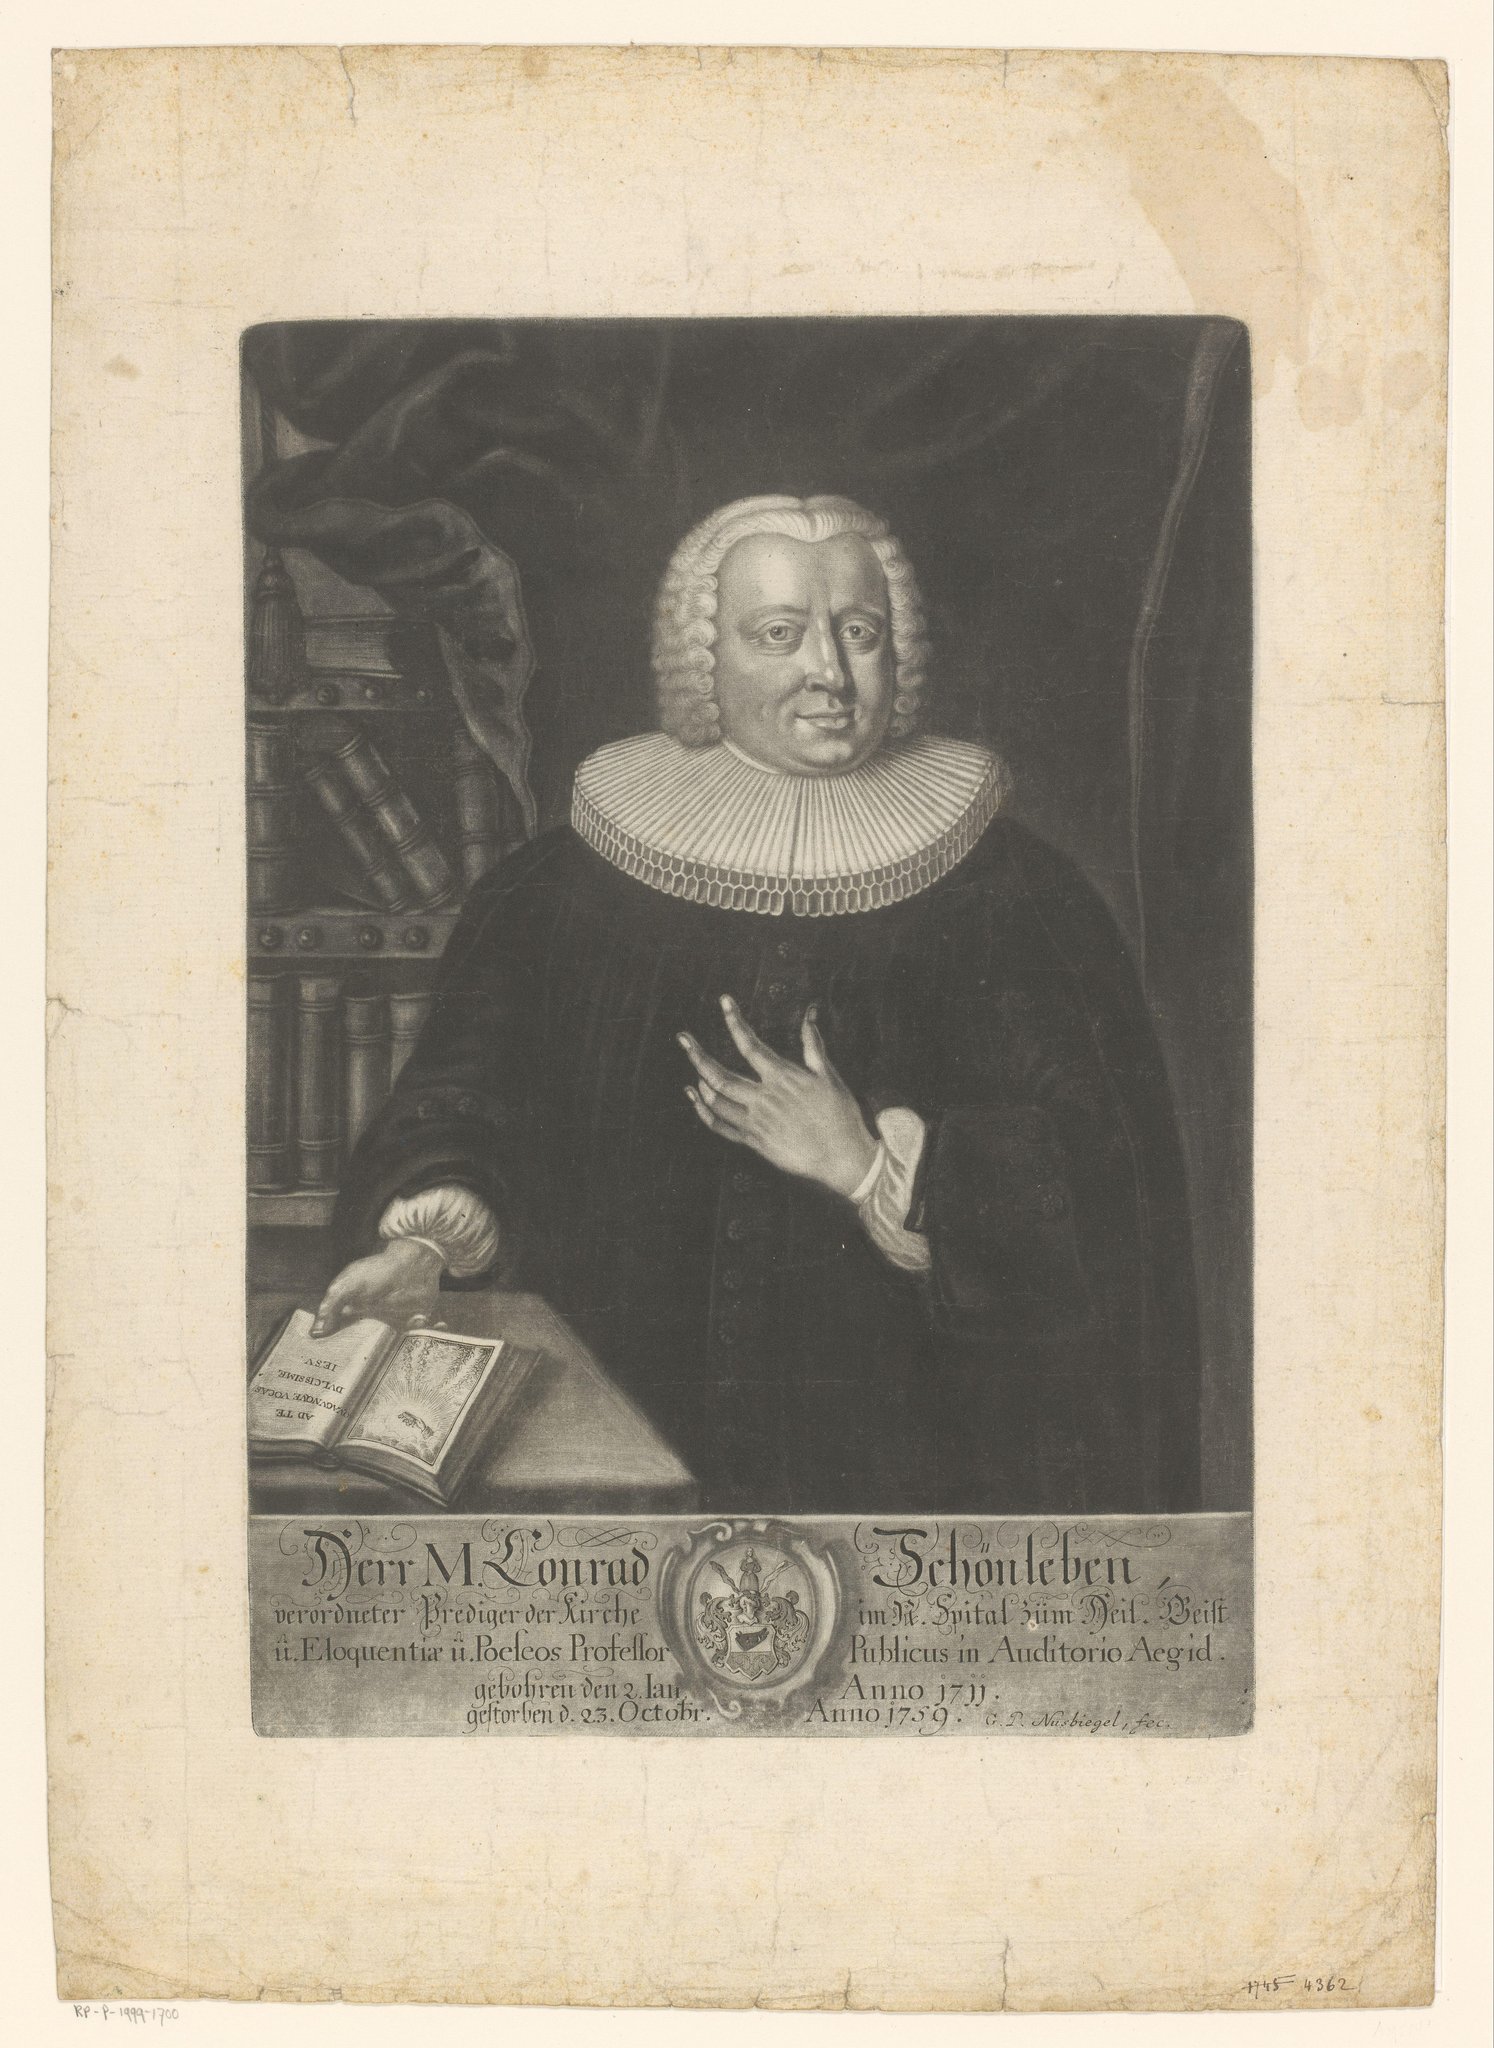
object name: print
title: Portret van Conrad Schönleben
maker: georg paul nusbiegel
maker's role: print maker, publisher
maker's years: 1713-1776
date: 1759-1776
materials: paper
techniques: mezzotint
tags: theologian, historical persons, book - mm - book open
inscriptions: check stamp: Lugt 1496c, collector's mark: Lugt 2228